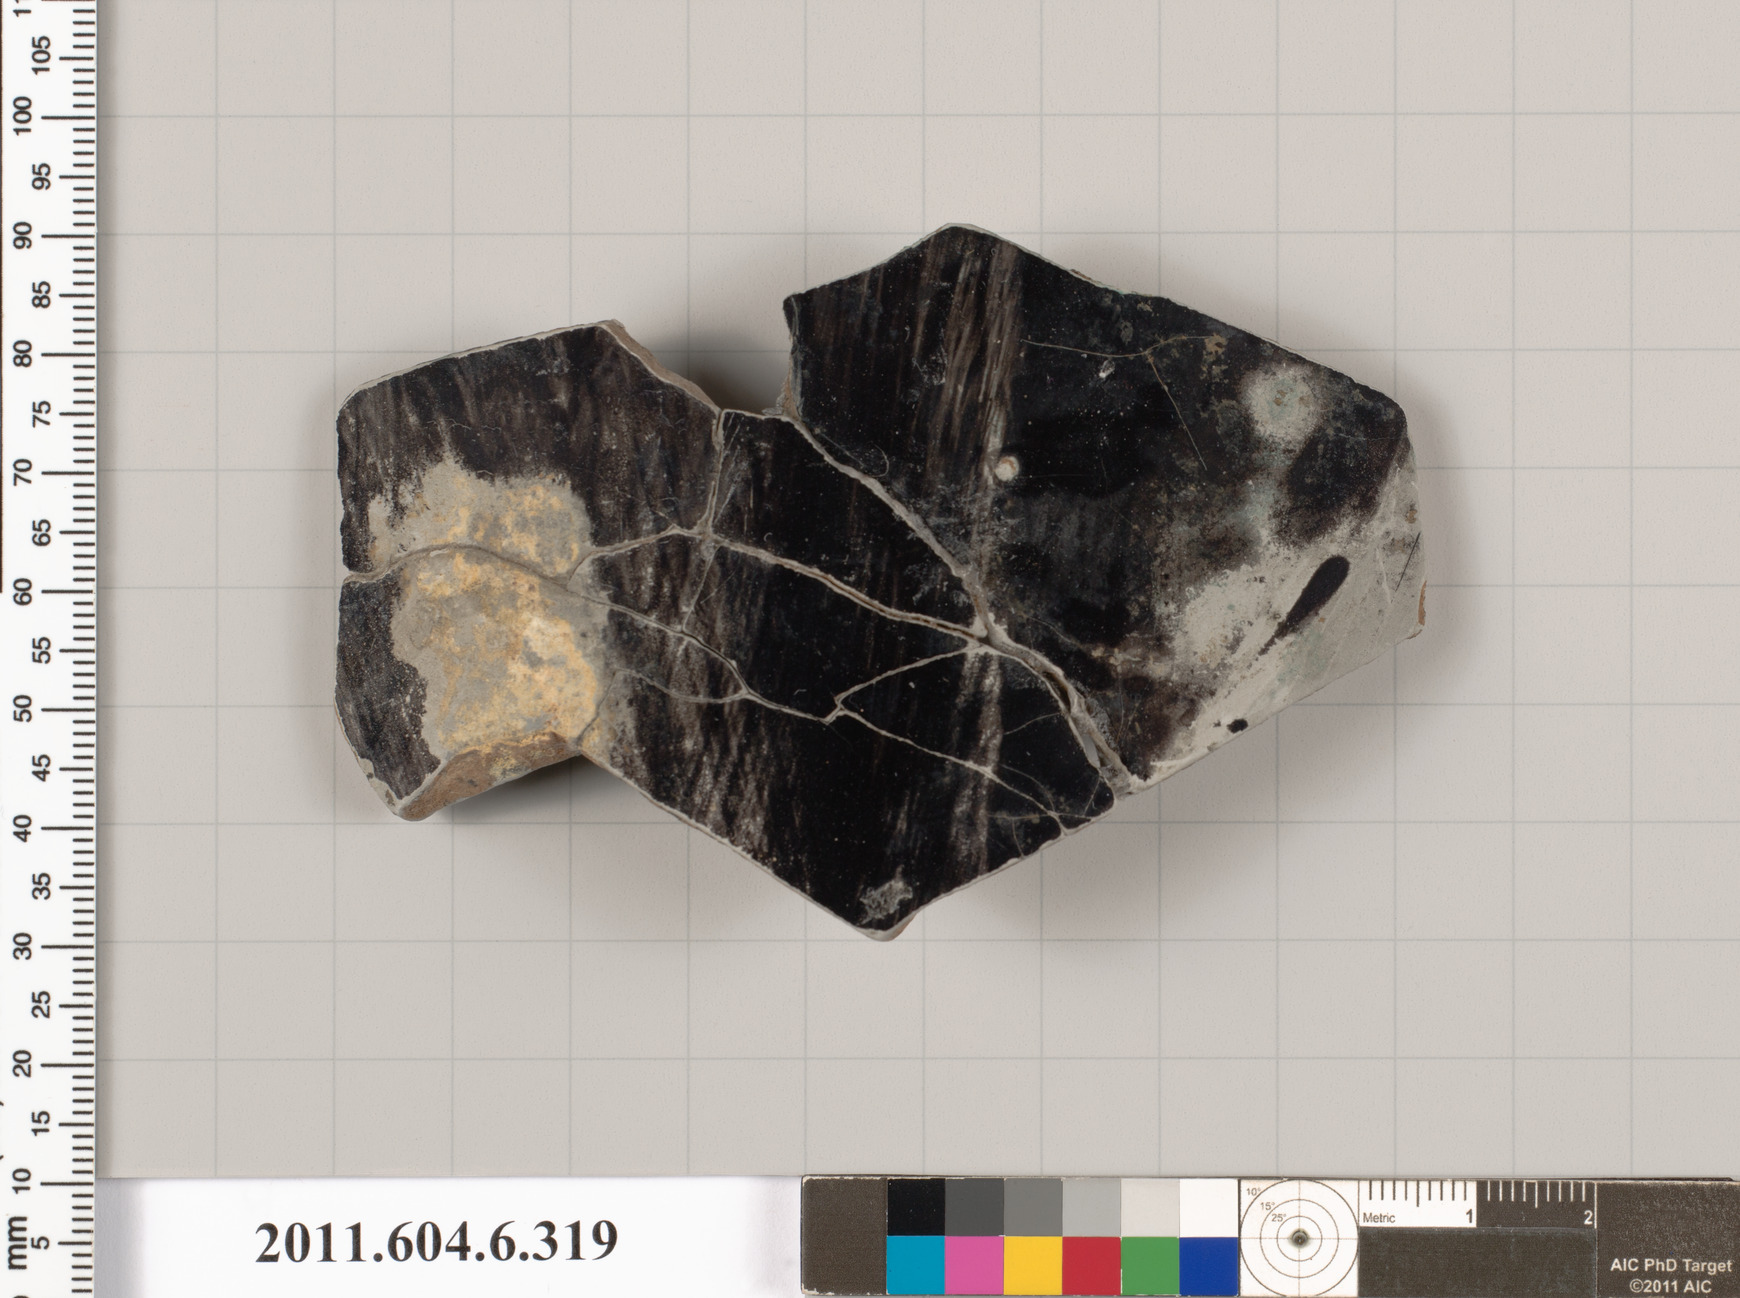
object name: undetermined shape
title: Terracotta fragment of an undetermined shape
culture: greek, attic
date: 600-401 BCE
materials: terracotta